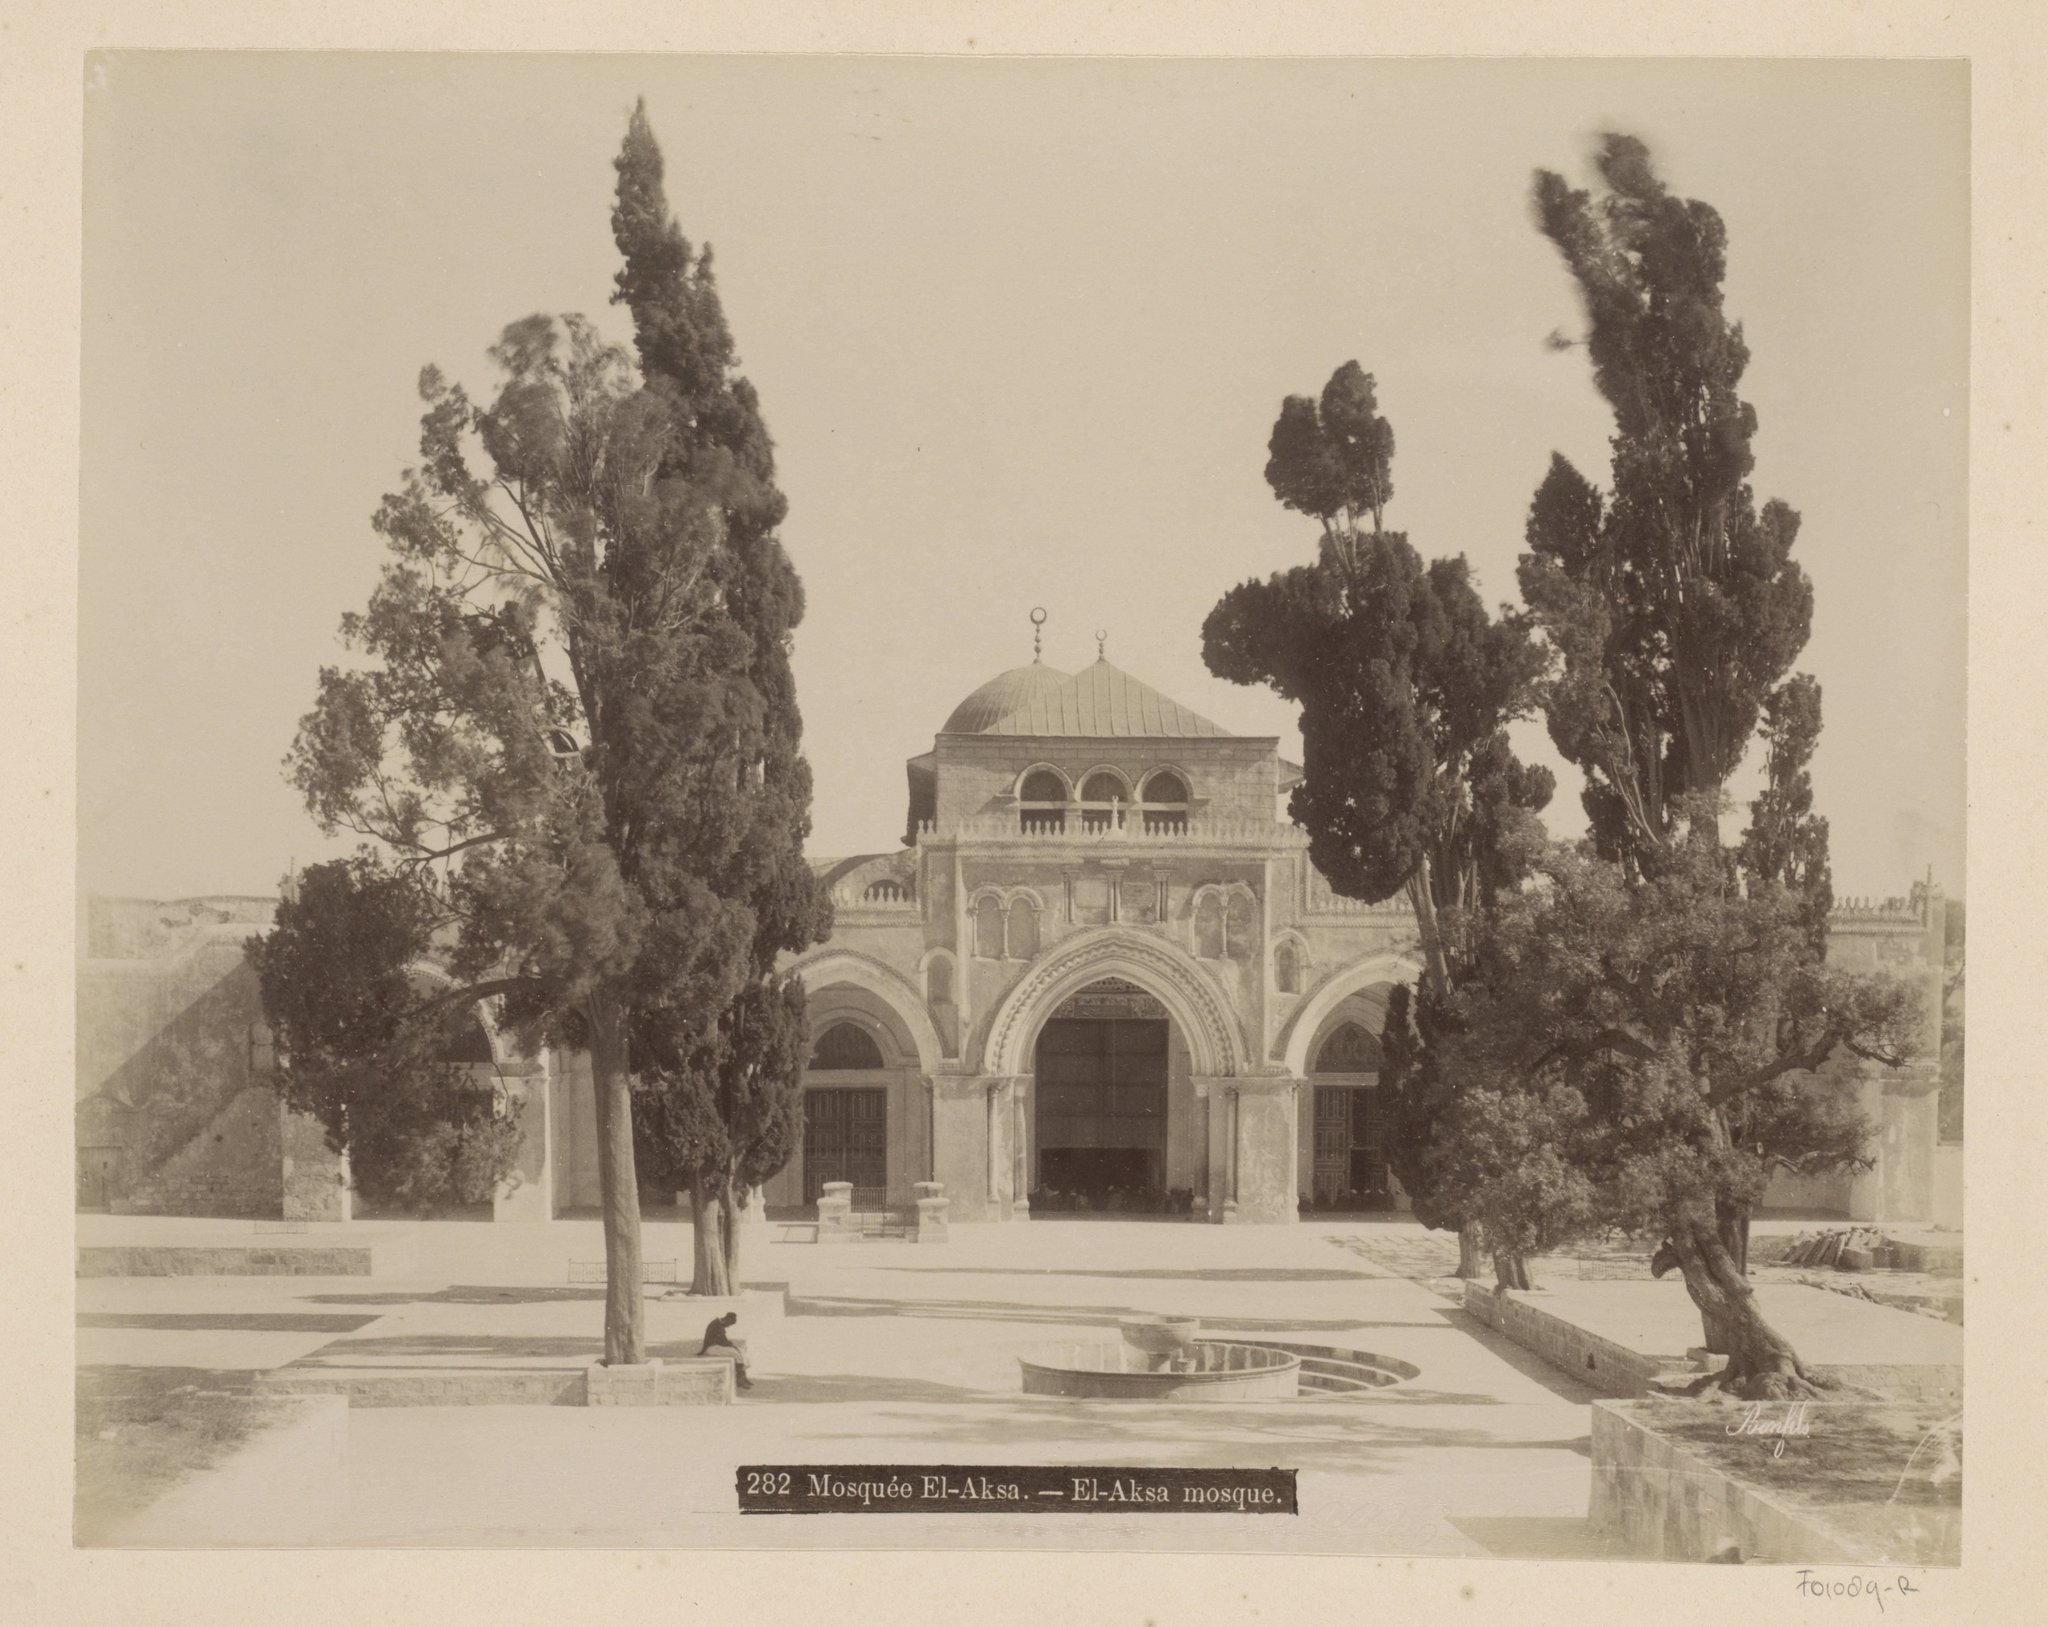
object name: photograph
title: Exterieur van de Al-Aqsamoskee op de Tempelberg in Jeruzalem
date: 1867-1895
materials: cardboard, paper, photographic support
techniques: albumen print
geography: jerusalem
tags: temple, shrine ~ islam, mohammedanism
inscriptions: negative number: ‘282’, inscription: ‘BFK Rives’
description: Onderdeel van Reisalbum met foto's van Jeruzalem en andere bijbelse plaatsen.